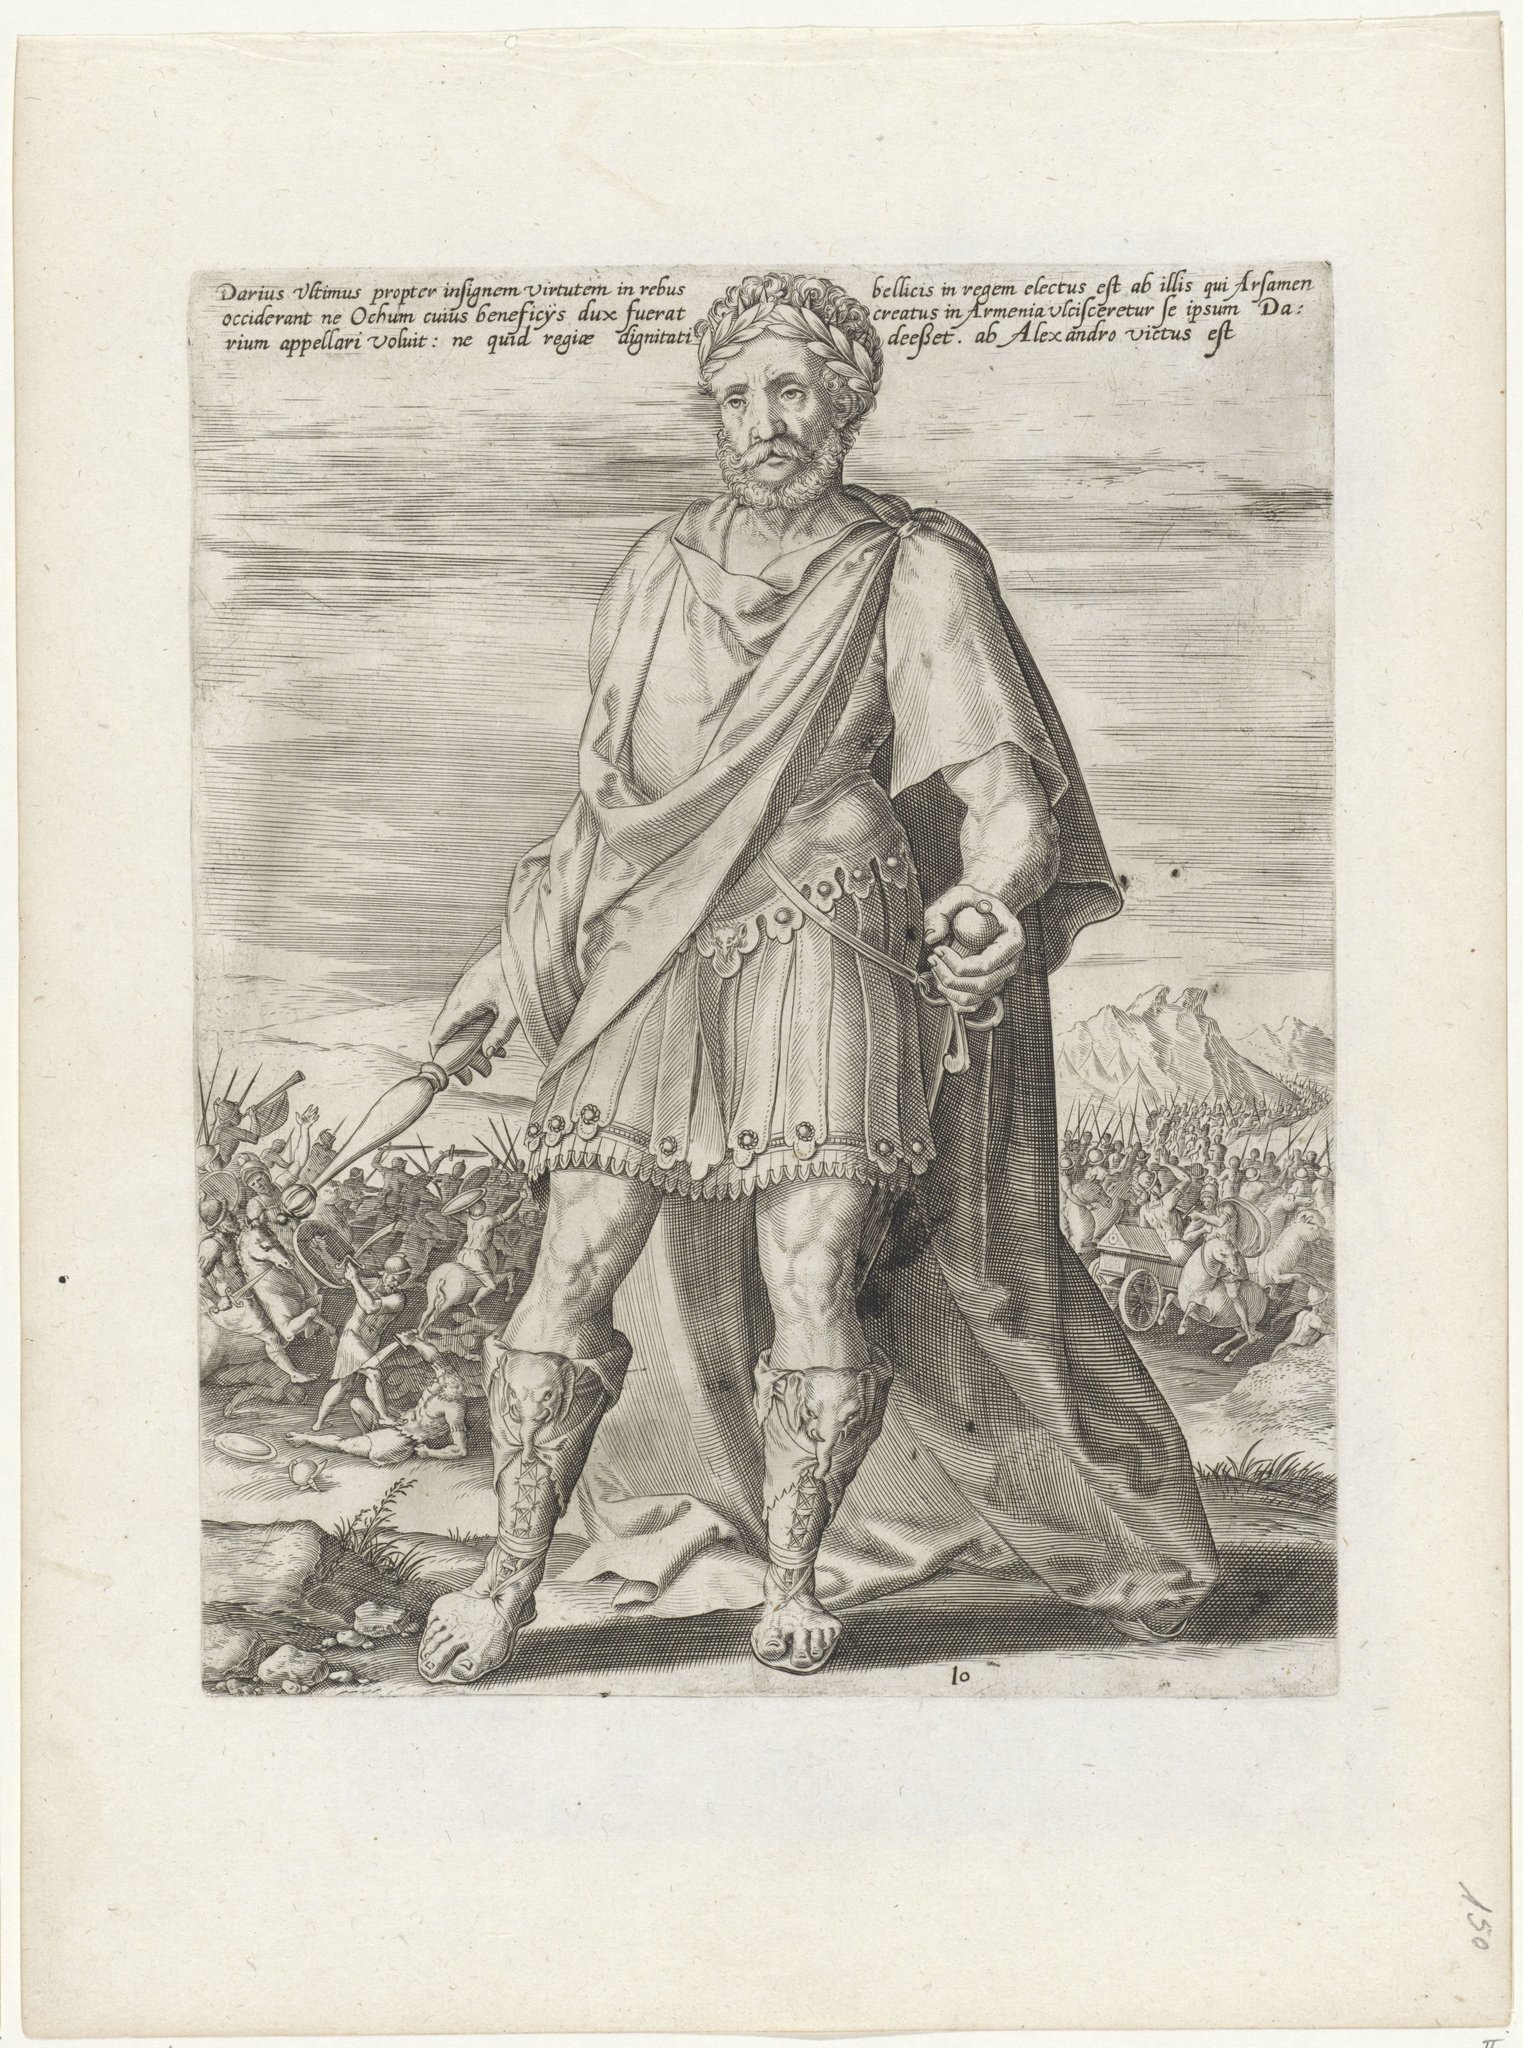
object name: print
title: Perzische koningen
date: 1585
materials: paper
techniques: engraving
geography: antwerp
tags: alexander fighting against darius at issus, male persons from classical history, ruler, sovereign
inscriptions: collector's mark: Lugt 2760, collector's mark: Lugt 2228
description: De eerdere staat van deze prent is verschenen in de serie met de titel: Series Regum Persarum (...).. Prent gebruikt in: Thesaurus sacrarum historiaru[m] veteris (et novi) testame[n]ti, elega[n]tissimis imaginibus expressu[m] excelle[n]tissimoru[m] in hac arte viroru[m] opera : nu[n]c primu[m] in luce[m] editus. Antwerpen: Gerard de Jode, 1585.